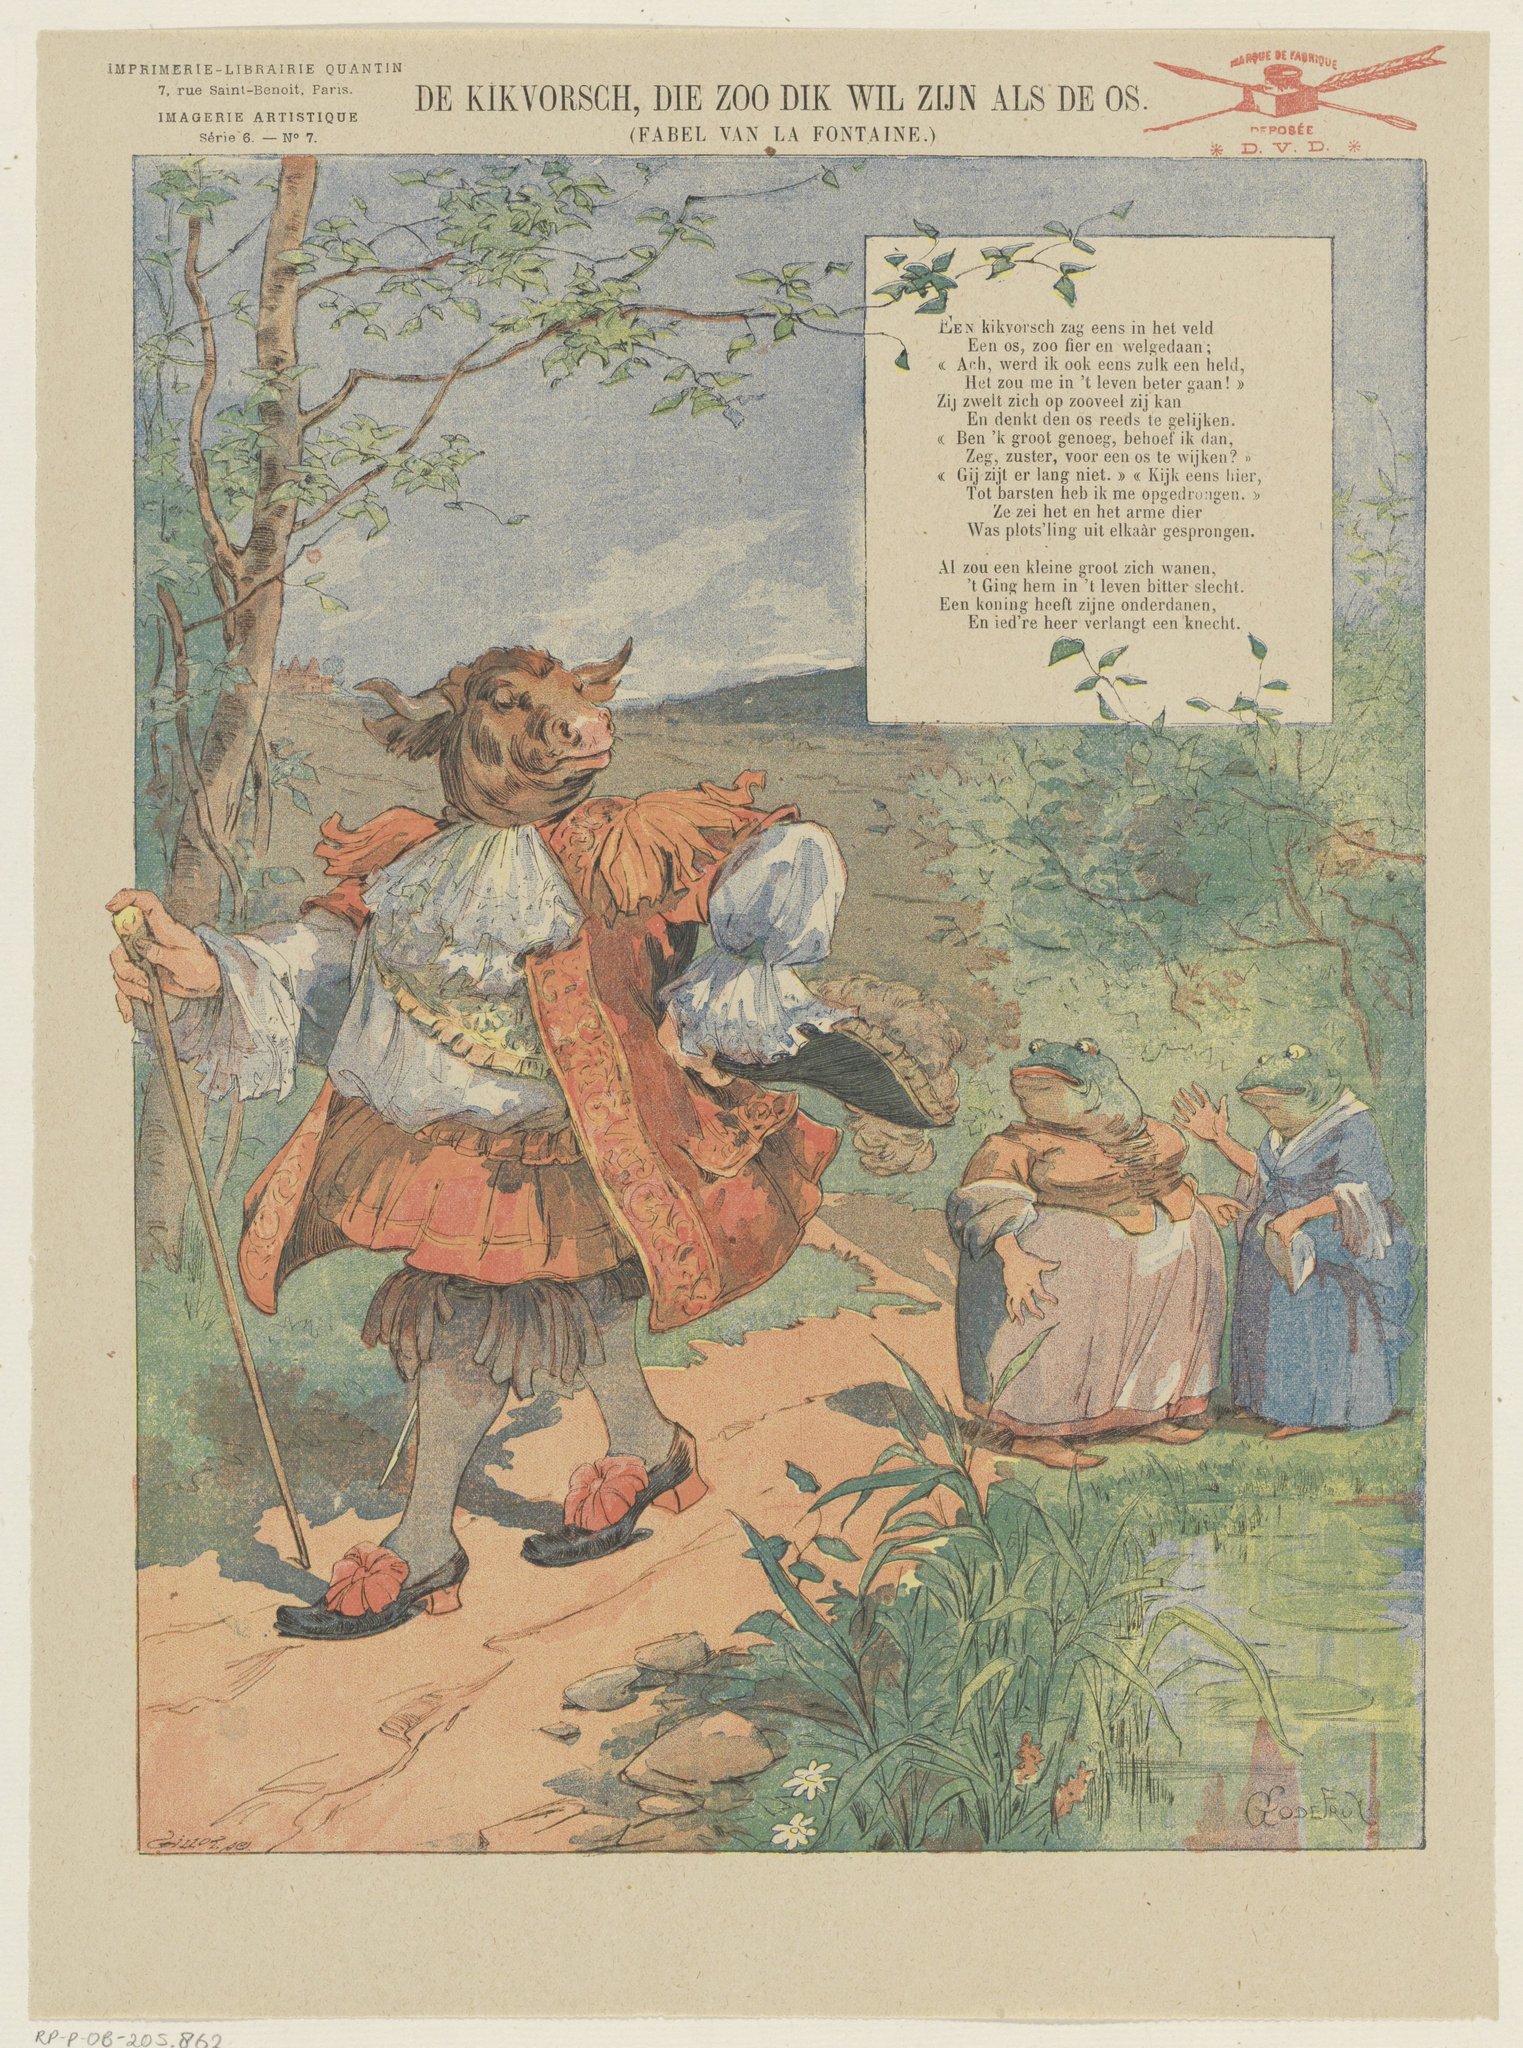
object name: popular print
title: De kikvorsch, die zoo dik wil zijn als de os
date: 1876-1890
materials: paper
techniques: lithograph, letterpress printing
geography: paris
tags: tailless amphibians: frog, animals acting as human beings, fables, ox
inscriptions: collector's mark: Lugt 2760, : ‘marque de fabrique / deposée / * D.V.D. *’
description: Blad met een grote voorstelling uit de fabel van Jean de La Fontaine, van de kikvors die zo dik wil zijn als de os. Rechtsboven een tekstblok met een vers. Genummerd linksboven: Série 6. - No. 7.